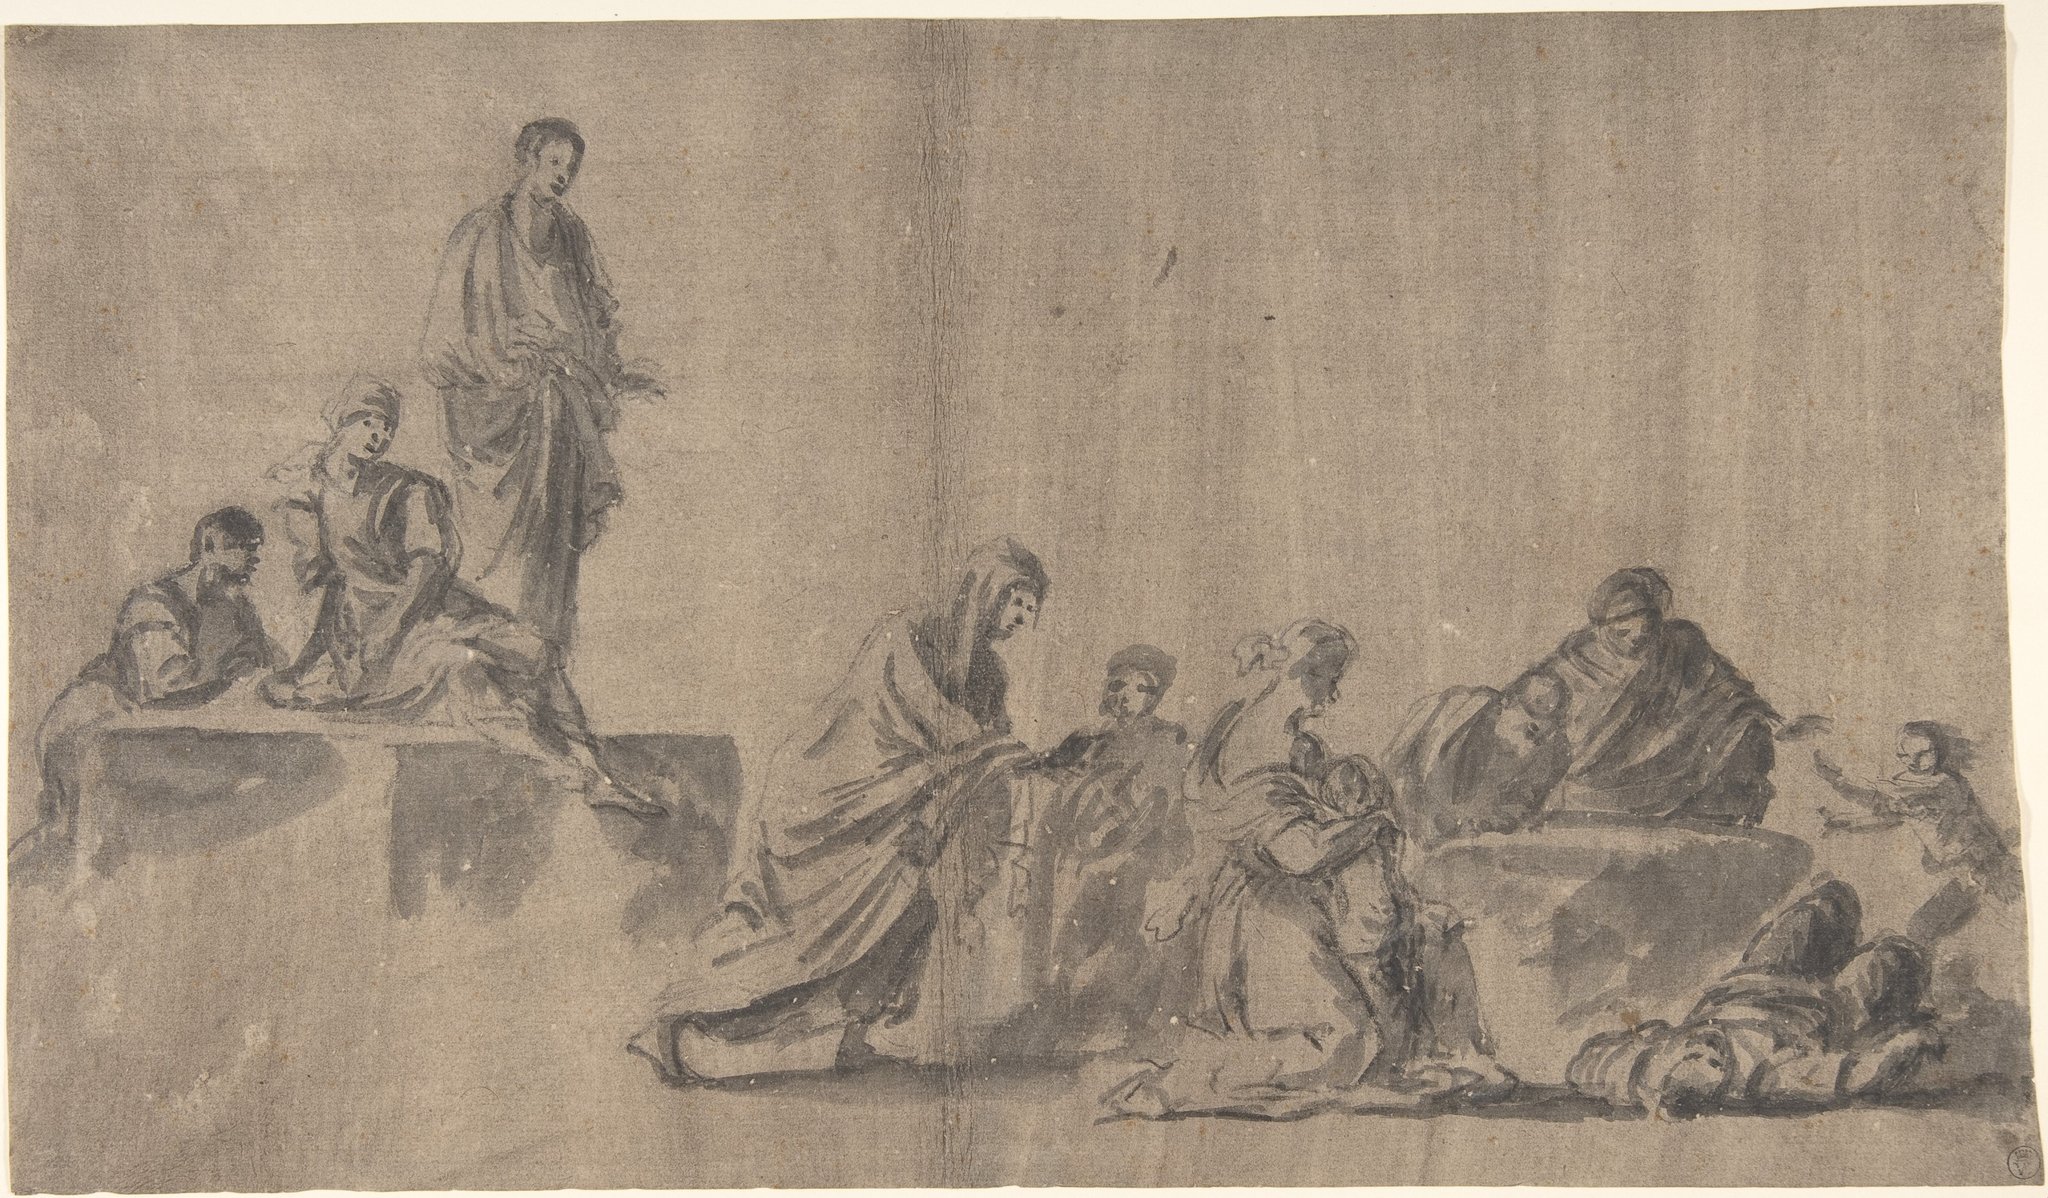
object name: drawing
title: Figures Surrounding a Man Lying on the Ground; verso: A Group of Figures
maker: anonymous, german, 18th century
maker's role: artist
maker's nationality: german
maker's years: 1700-1800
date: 1701-1800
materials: chalk, ink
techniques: brush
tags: men,women